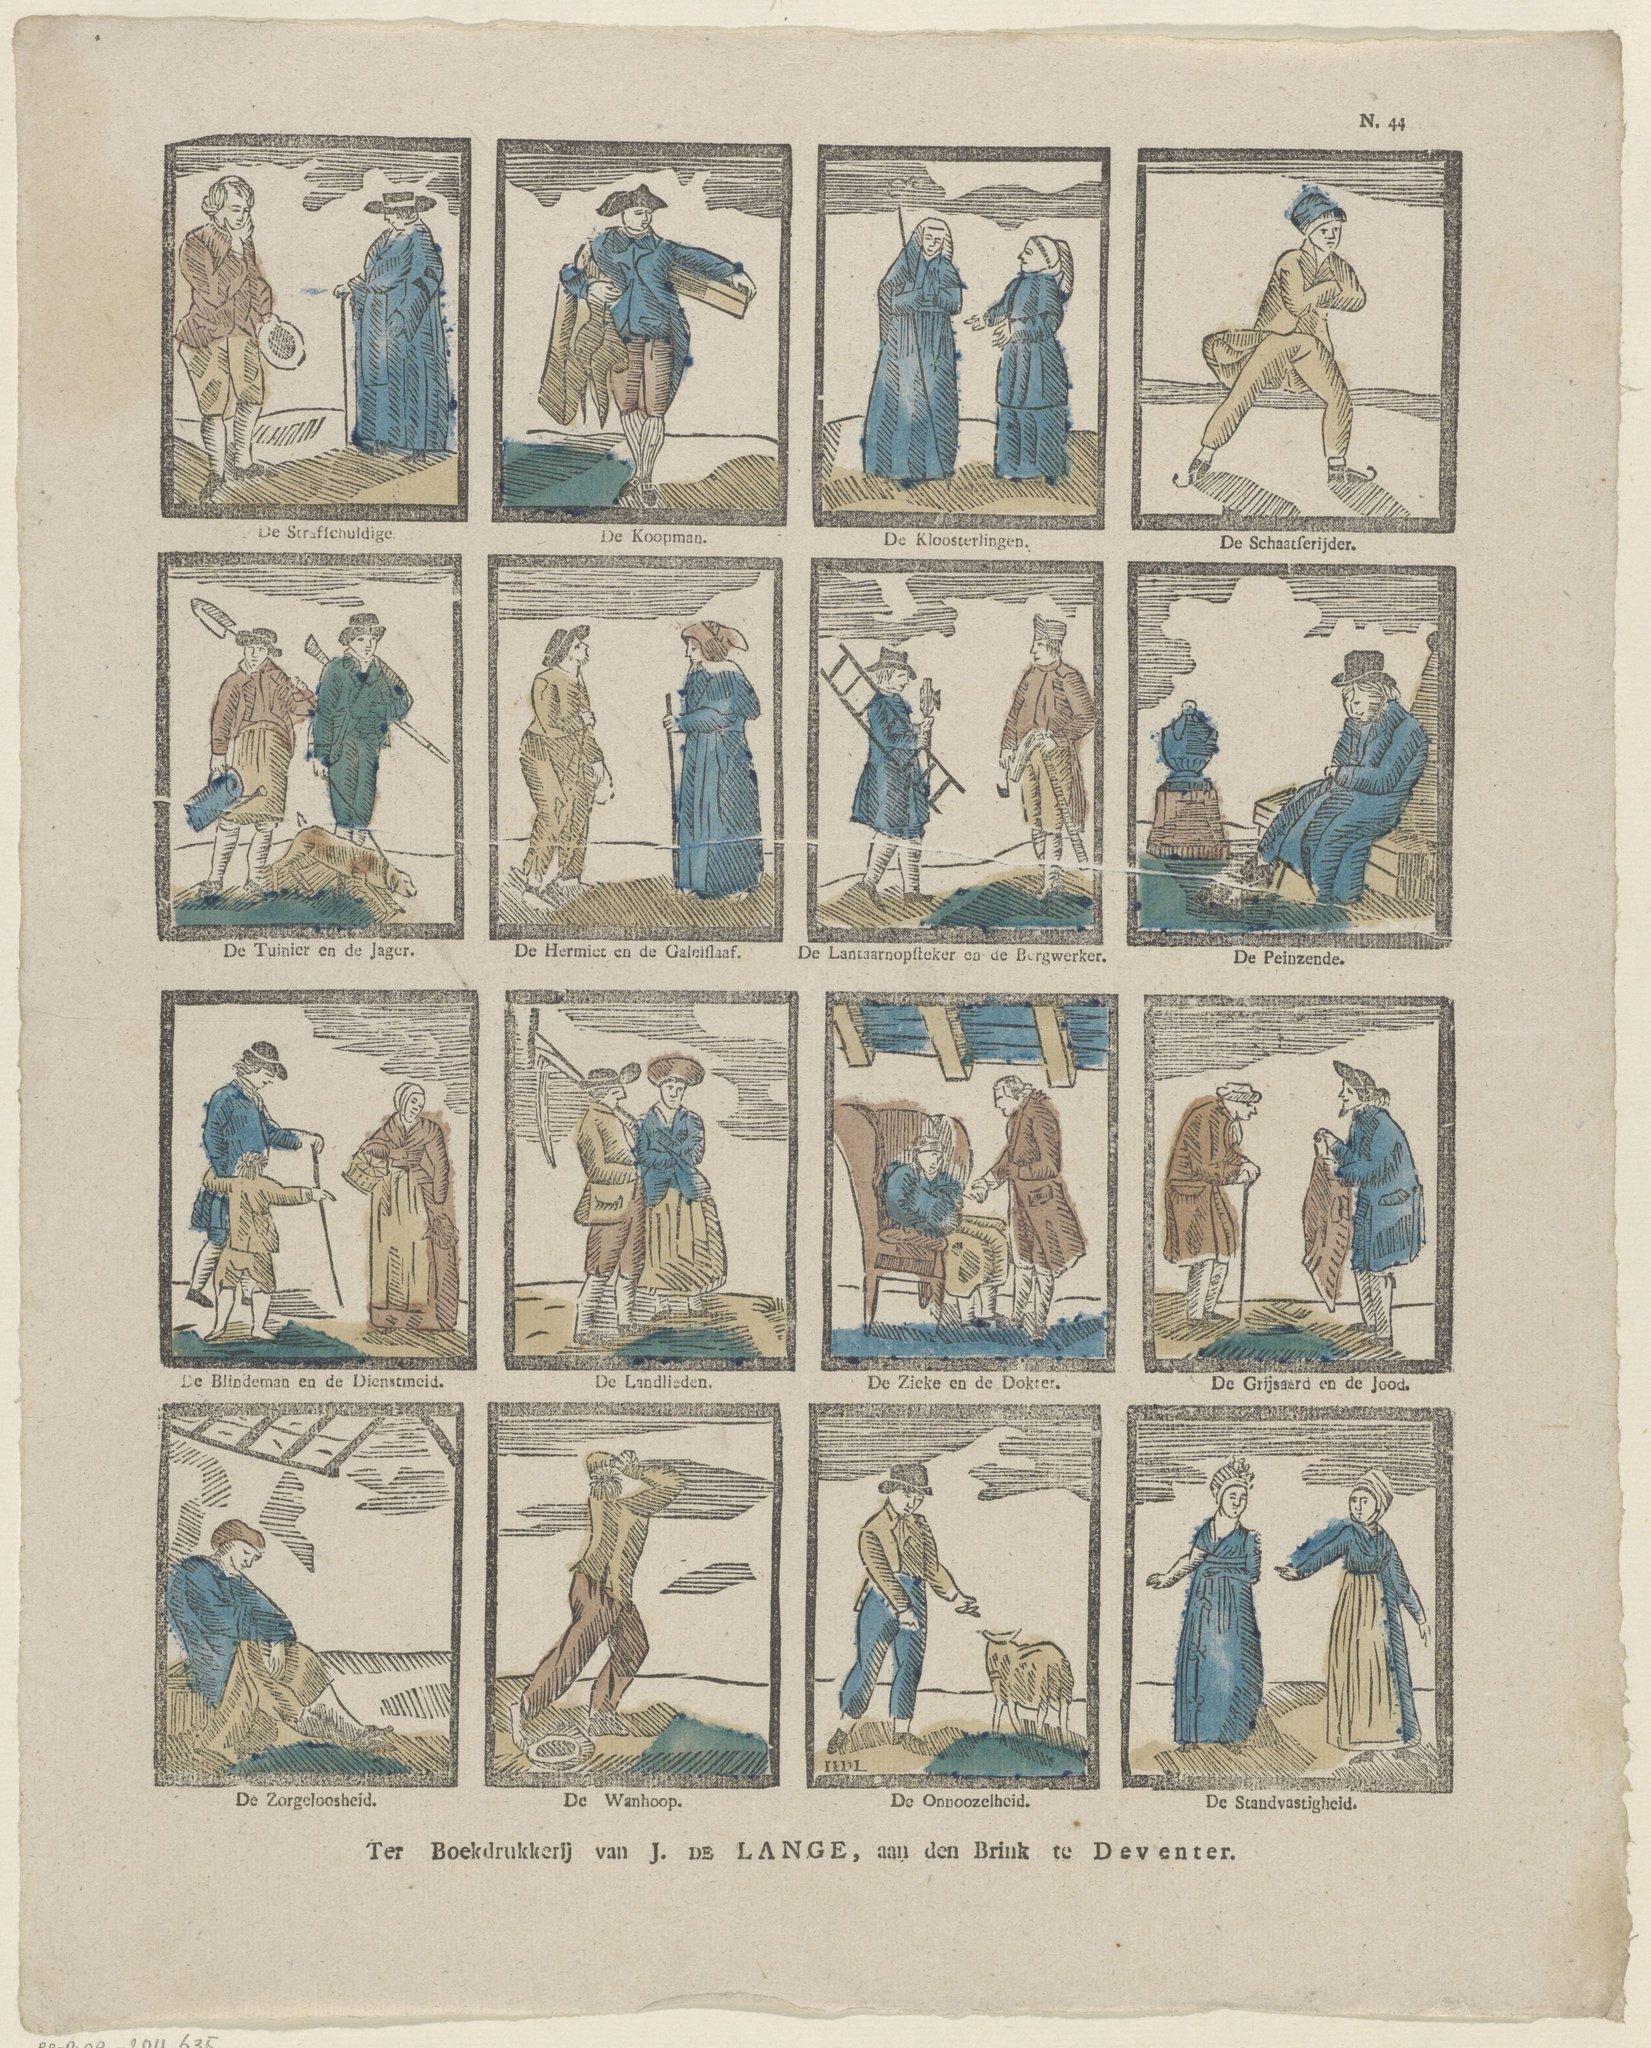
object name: popular print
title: Figuren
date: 1822-1849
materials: paper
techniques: colour, letterpress printing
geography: deventer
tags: human types, despair; 'disperatione' (ripa), working class, labourers, physician, doctor, constancy, tenacity; 'costanza', 'tenacità' (ripa), merchant, salesman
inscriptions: collector's mark: Lugt 2760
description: Blad met 16 voorstellingen van figuren, beroepen en verbeeldingen van onder andere de zorgeloosheid en de wanhoop. Onder elke afbeelding een onderschrift. Genummerd rechtsboven: N. 44.